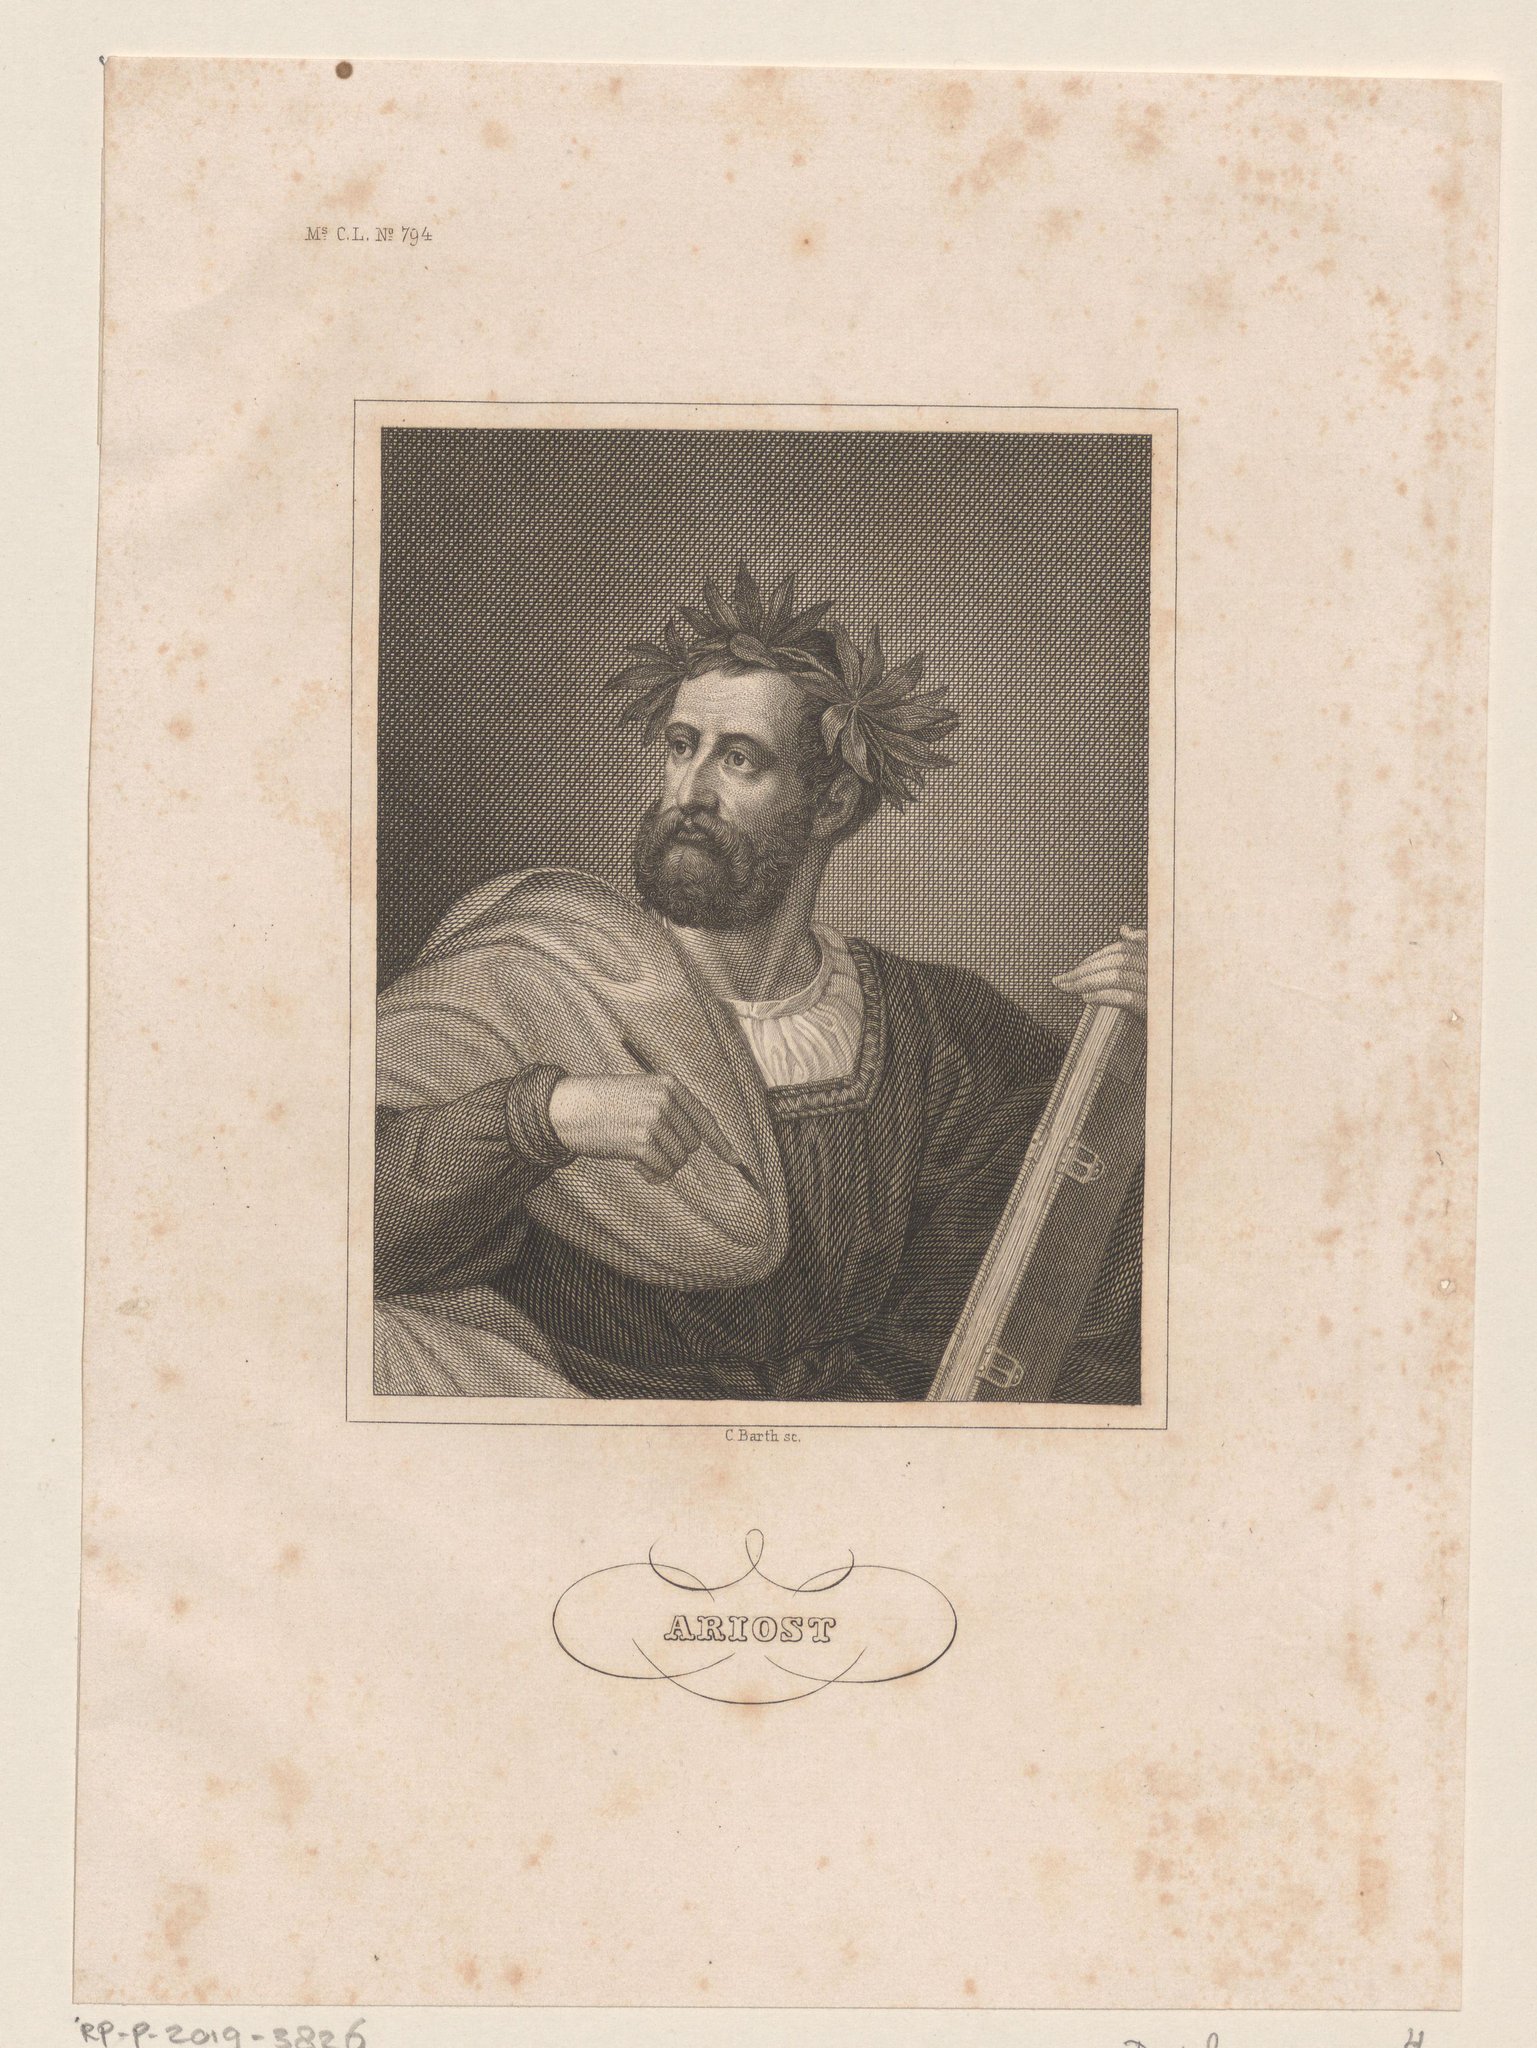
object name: print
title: Portret van Ludovico Ariosto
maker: karl barth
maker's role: print maker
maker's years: 1787-1853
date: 1828-1853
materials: paper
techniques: engraving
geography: hildburghausen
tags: ludovico ariosto, historical persons